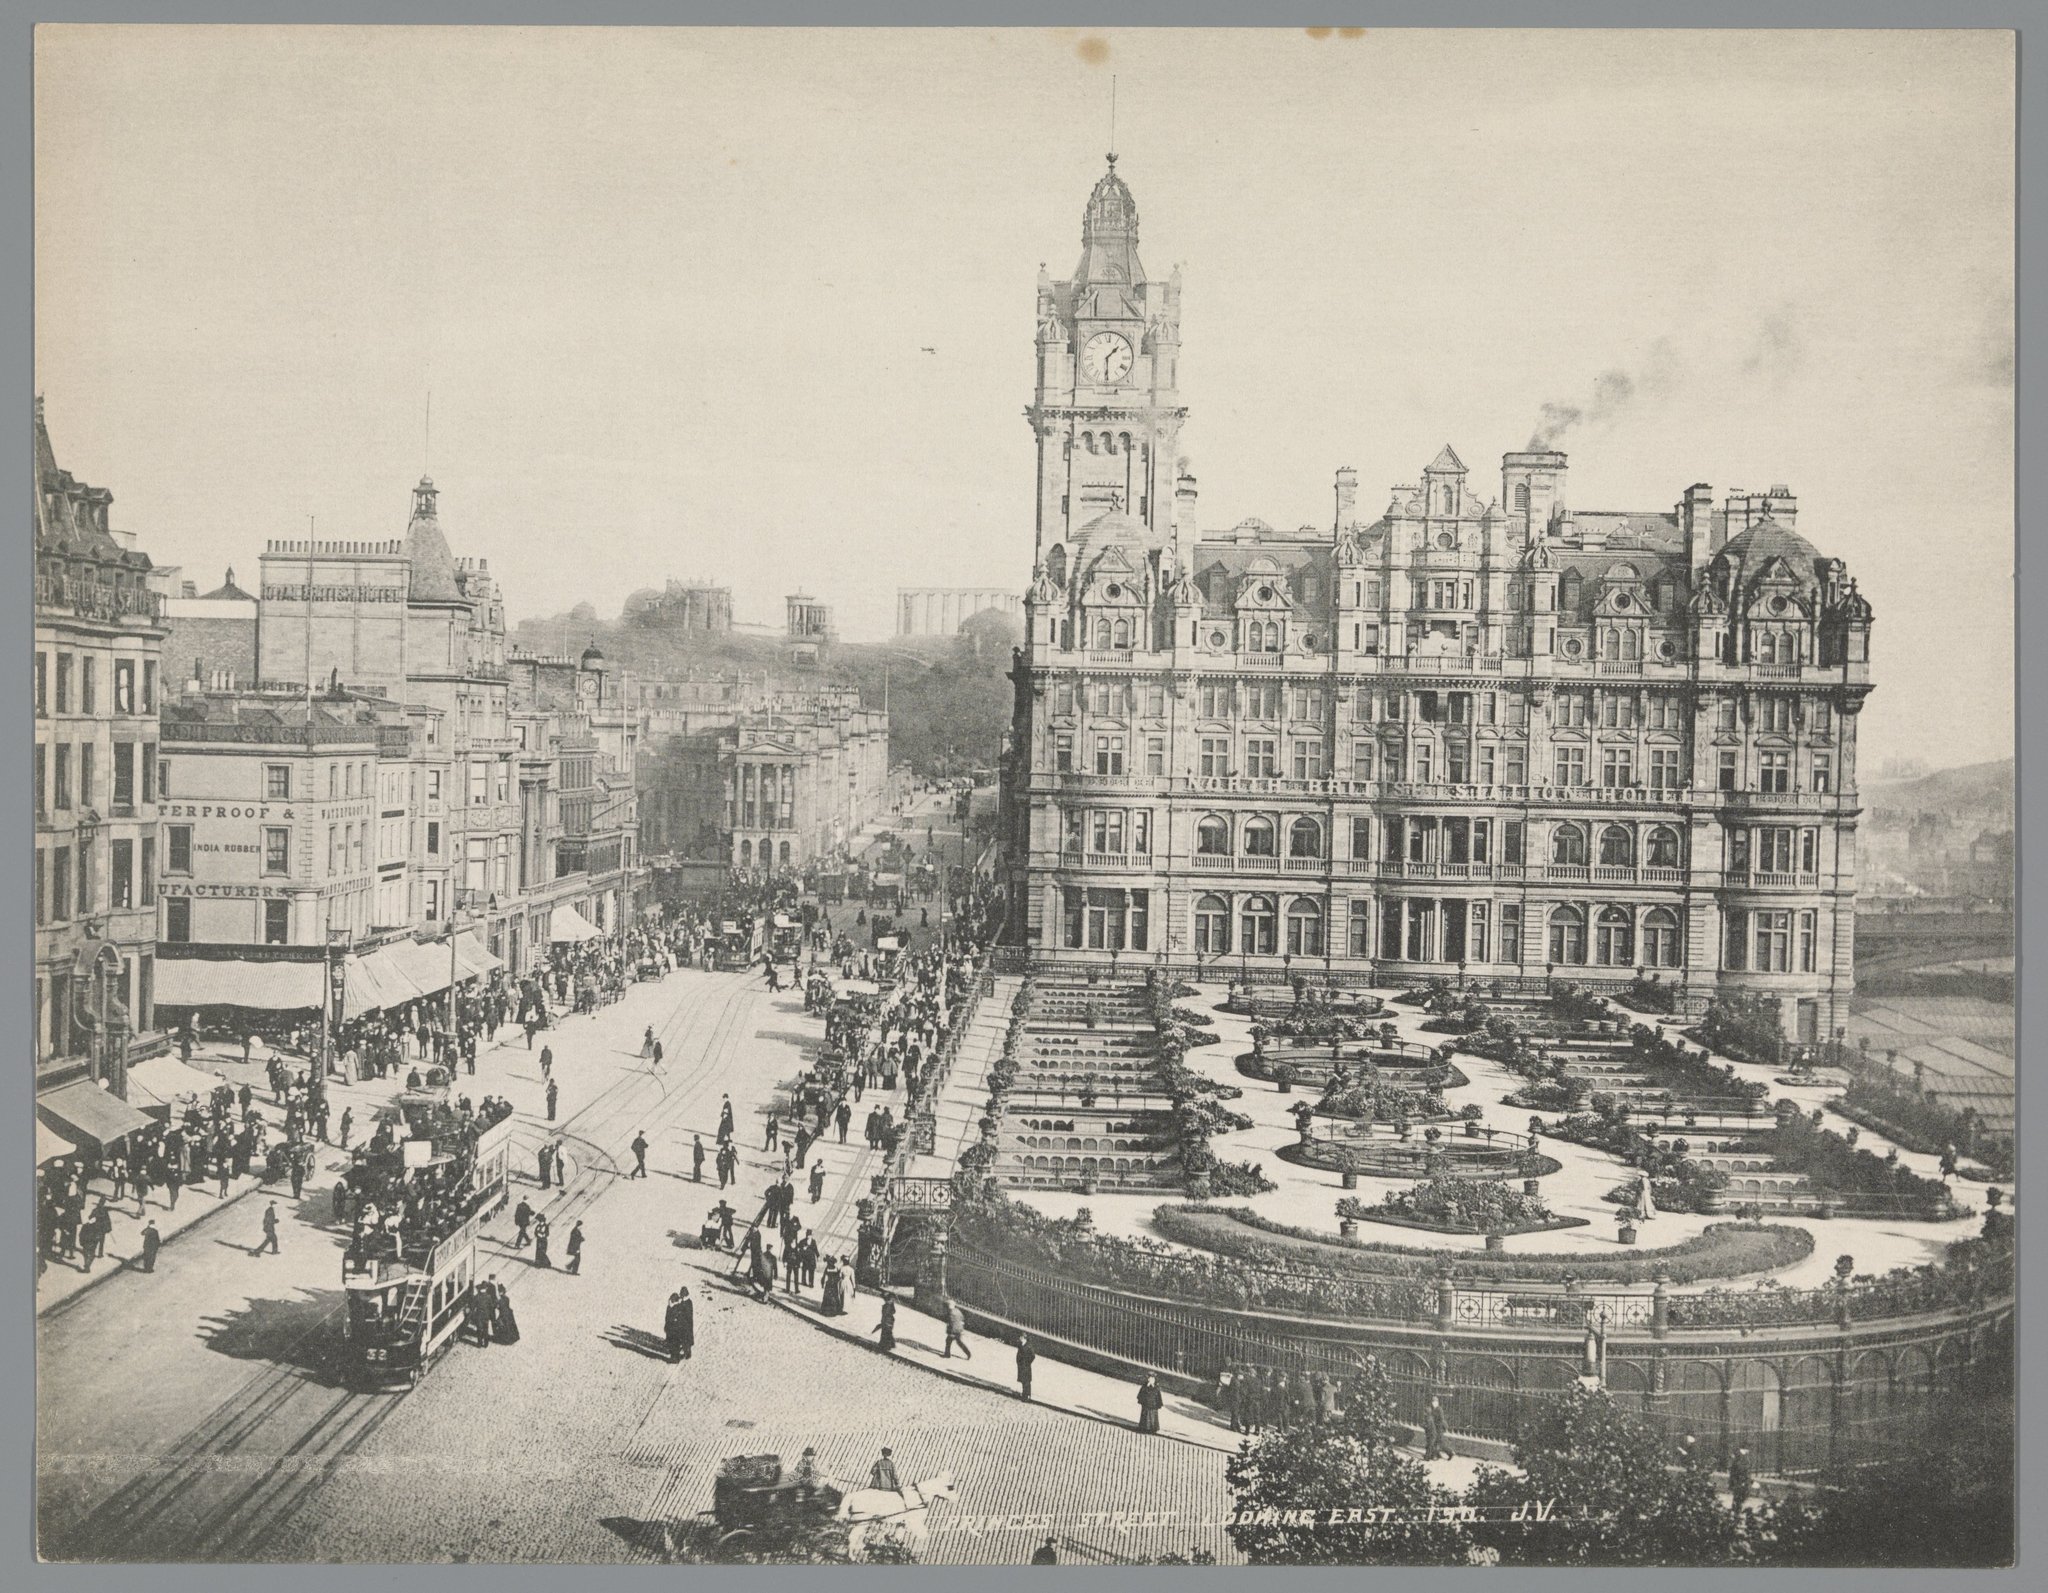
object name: print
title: Stadsgezicht van Edinburgh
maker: Anonymous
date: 1860-1915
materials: paper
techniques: photograph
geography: united kingdom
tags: edinburgh